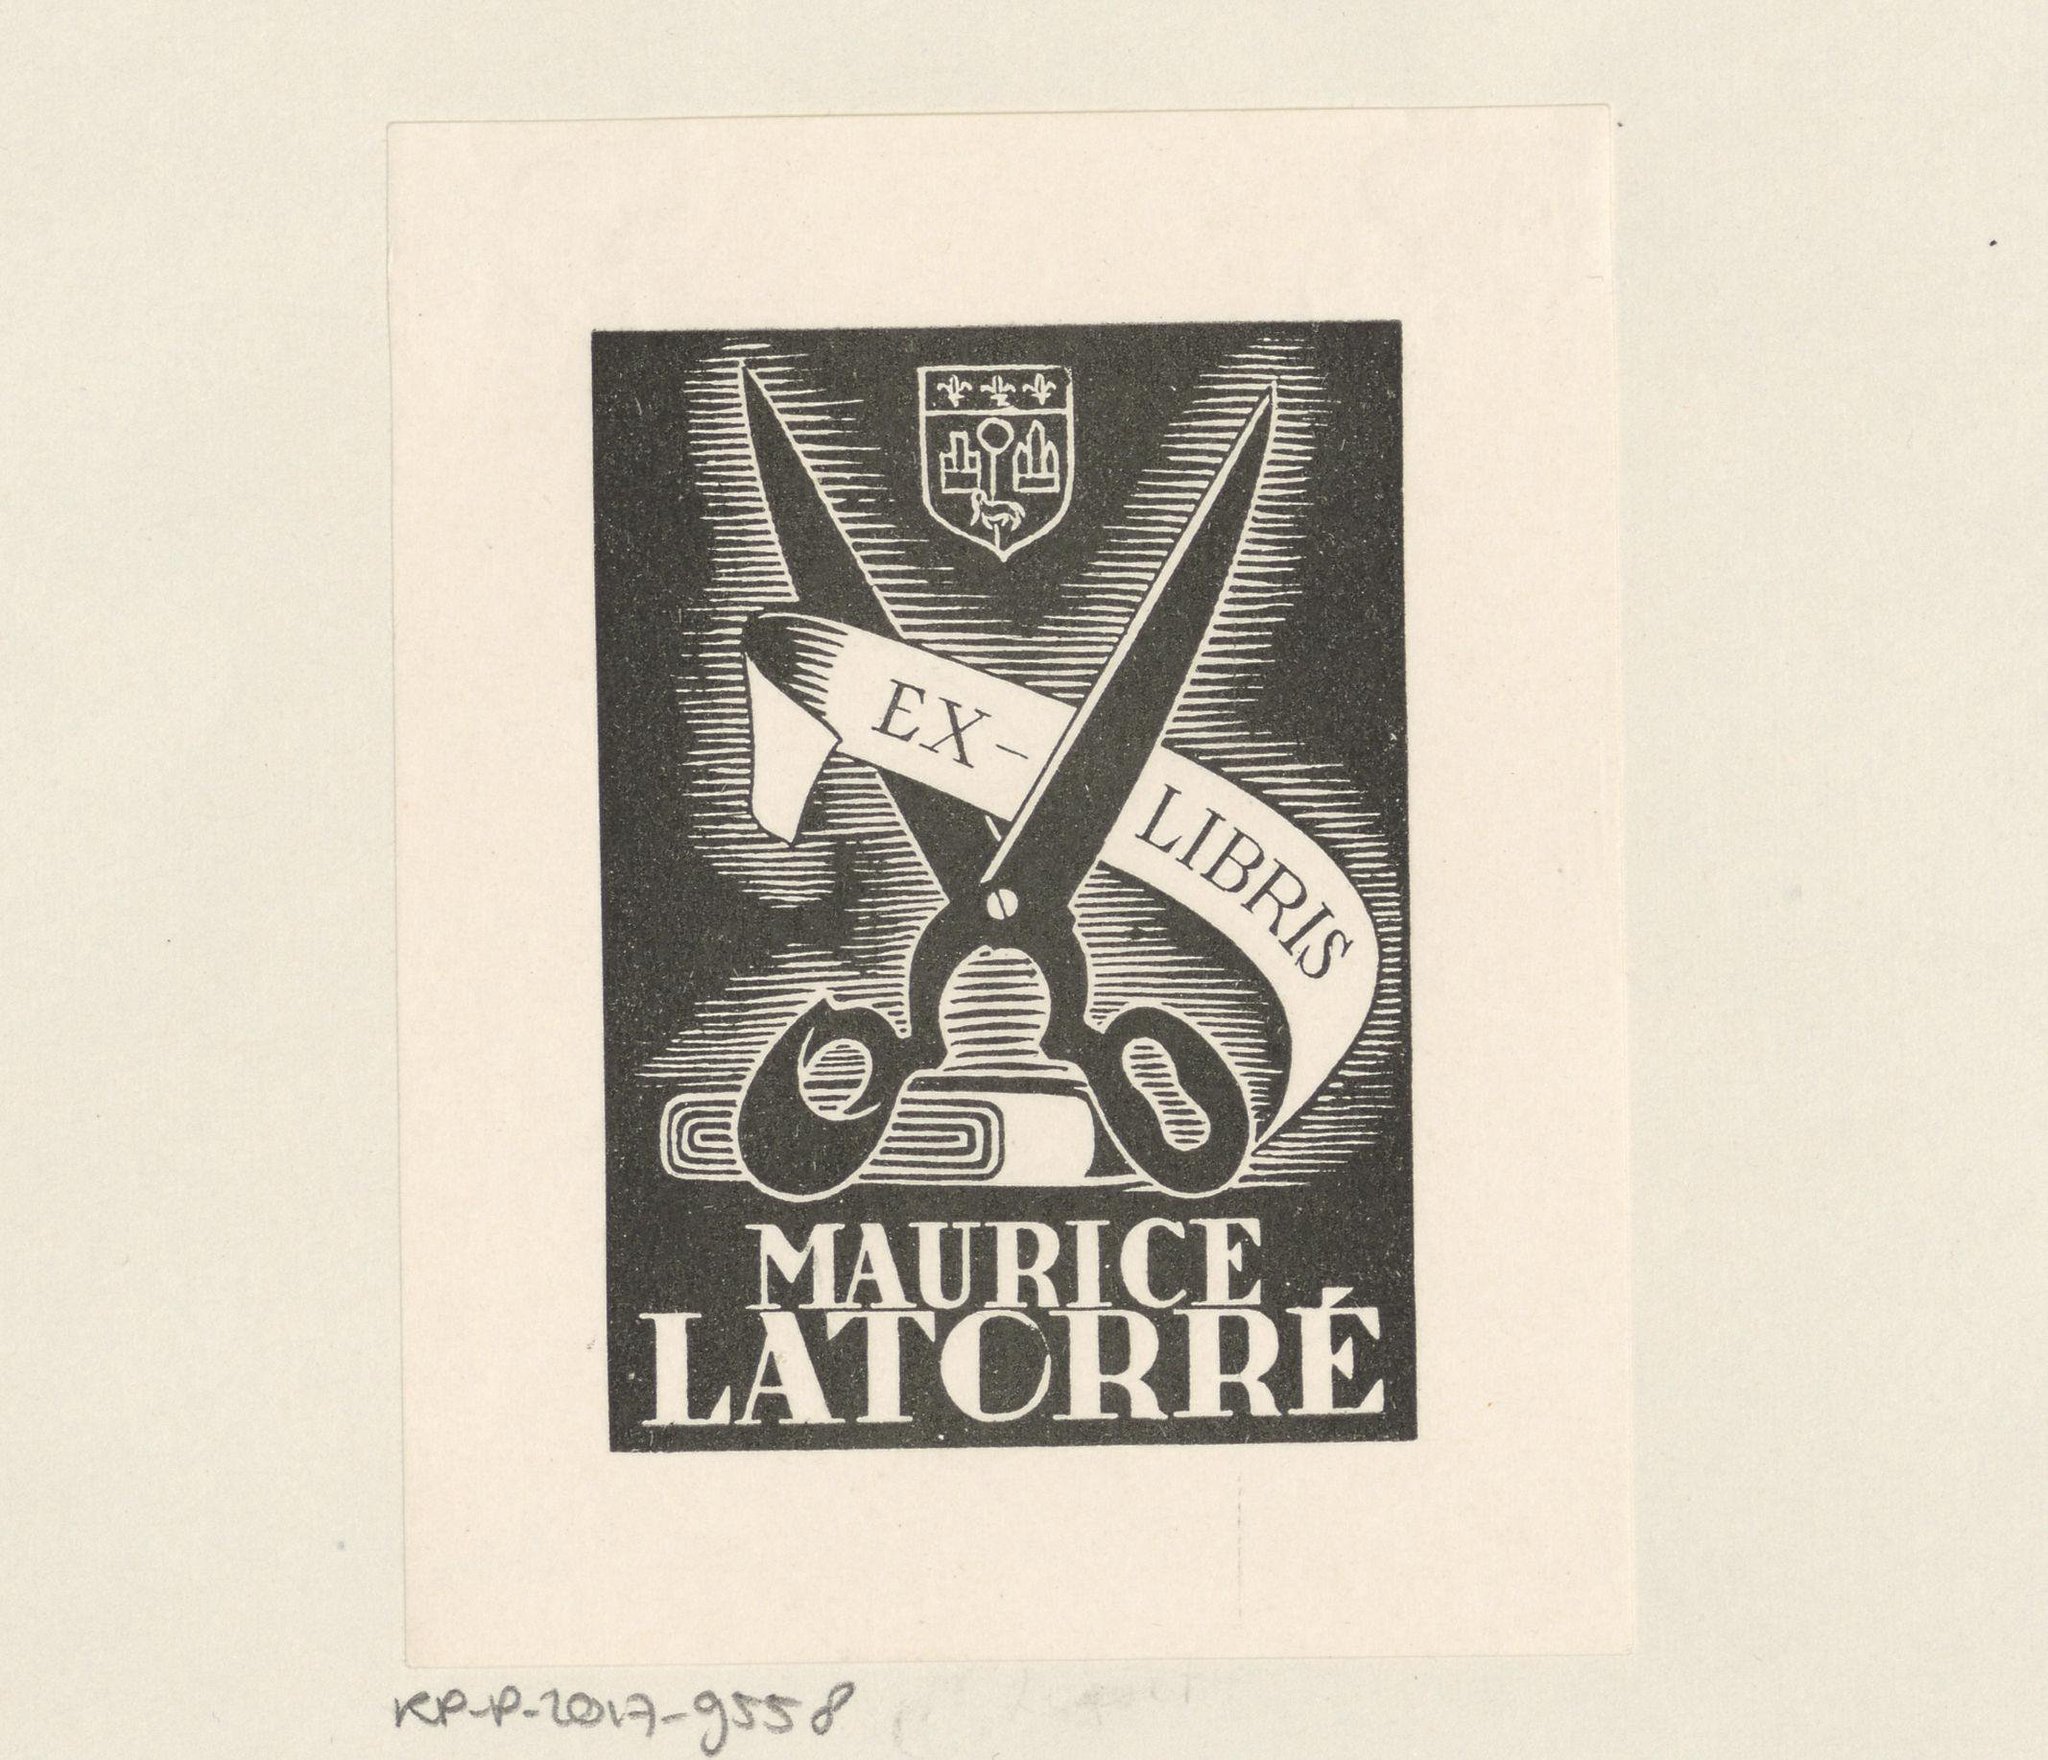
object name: bookplate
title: Ex libris van Maurice Latorré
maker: Anonymous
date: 1900-1999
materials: paper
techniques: printing block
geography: france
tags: tools, aids, implements ~ crafts and industries: scissors, armorial bearing, heraldry